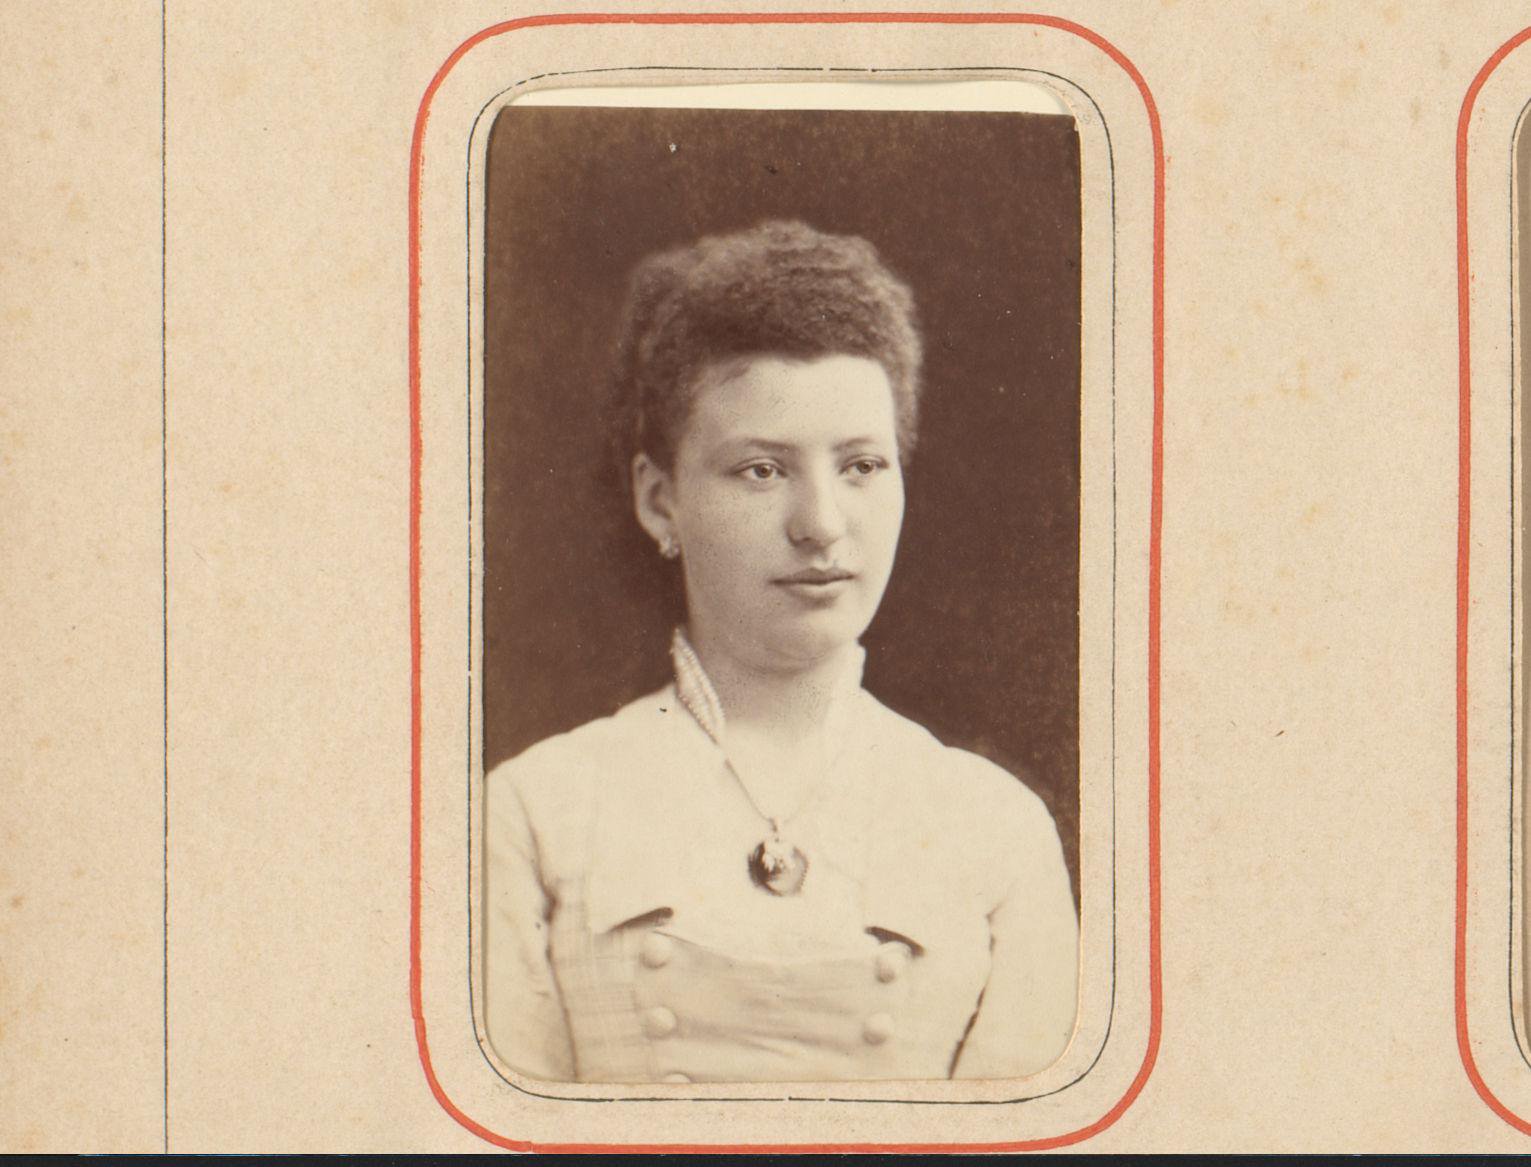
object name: album leaf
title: Portret van een onbekende vrouw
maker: Anonymous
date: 1880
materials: cardboard, paper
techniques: albumen print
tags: anonymous historical person portrayed - bb - woman